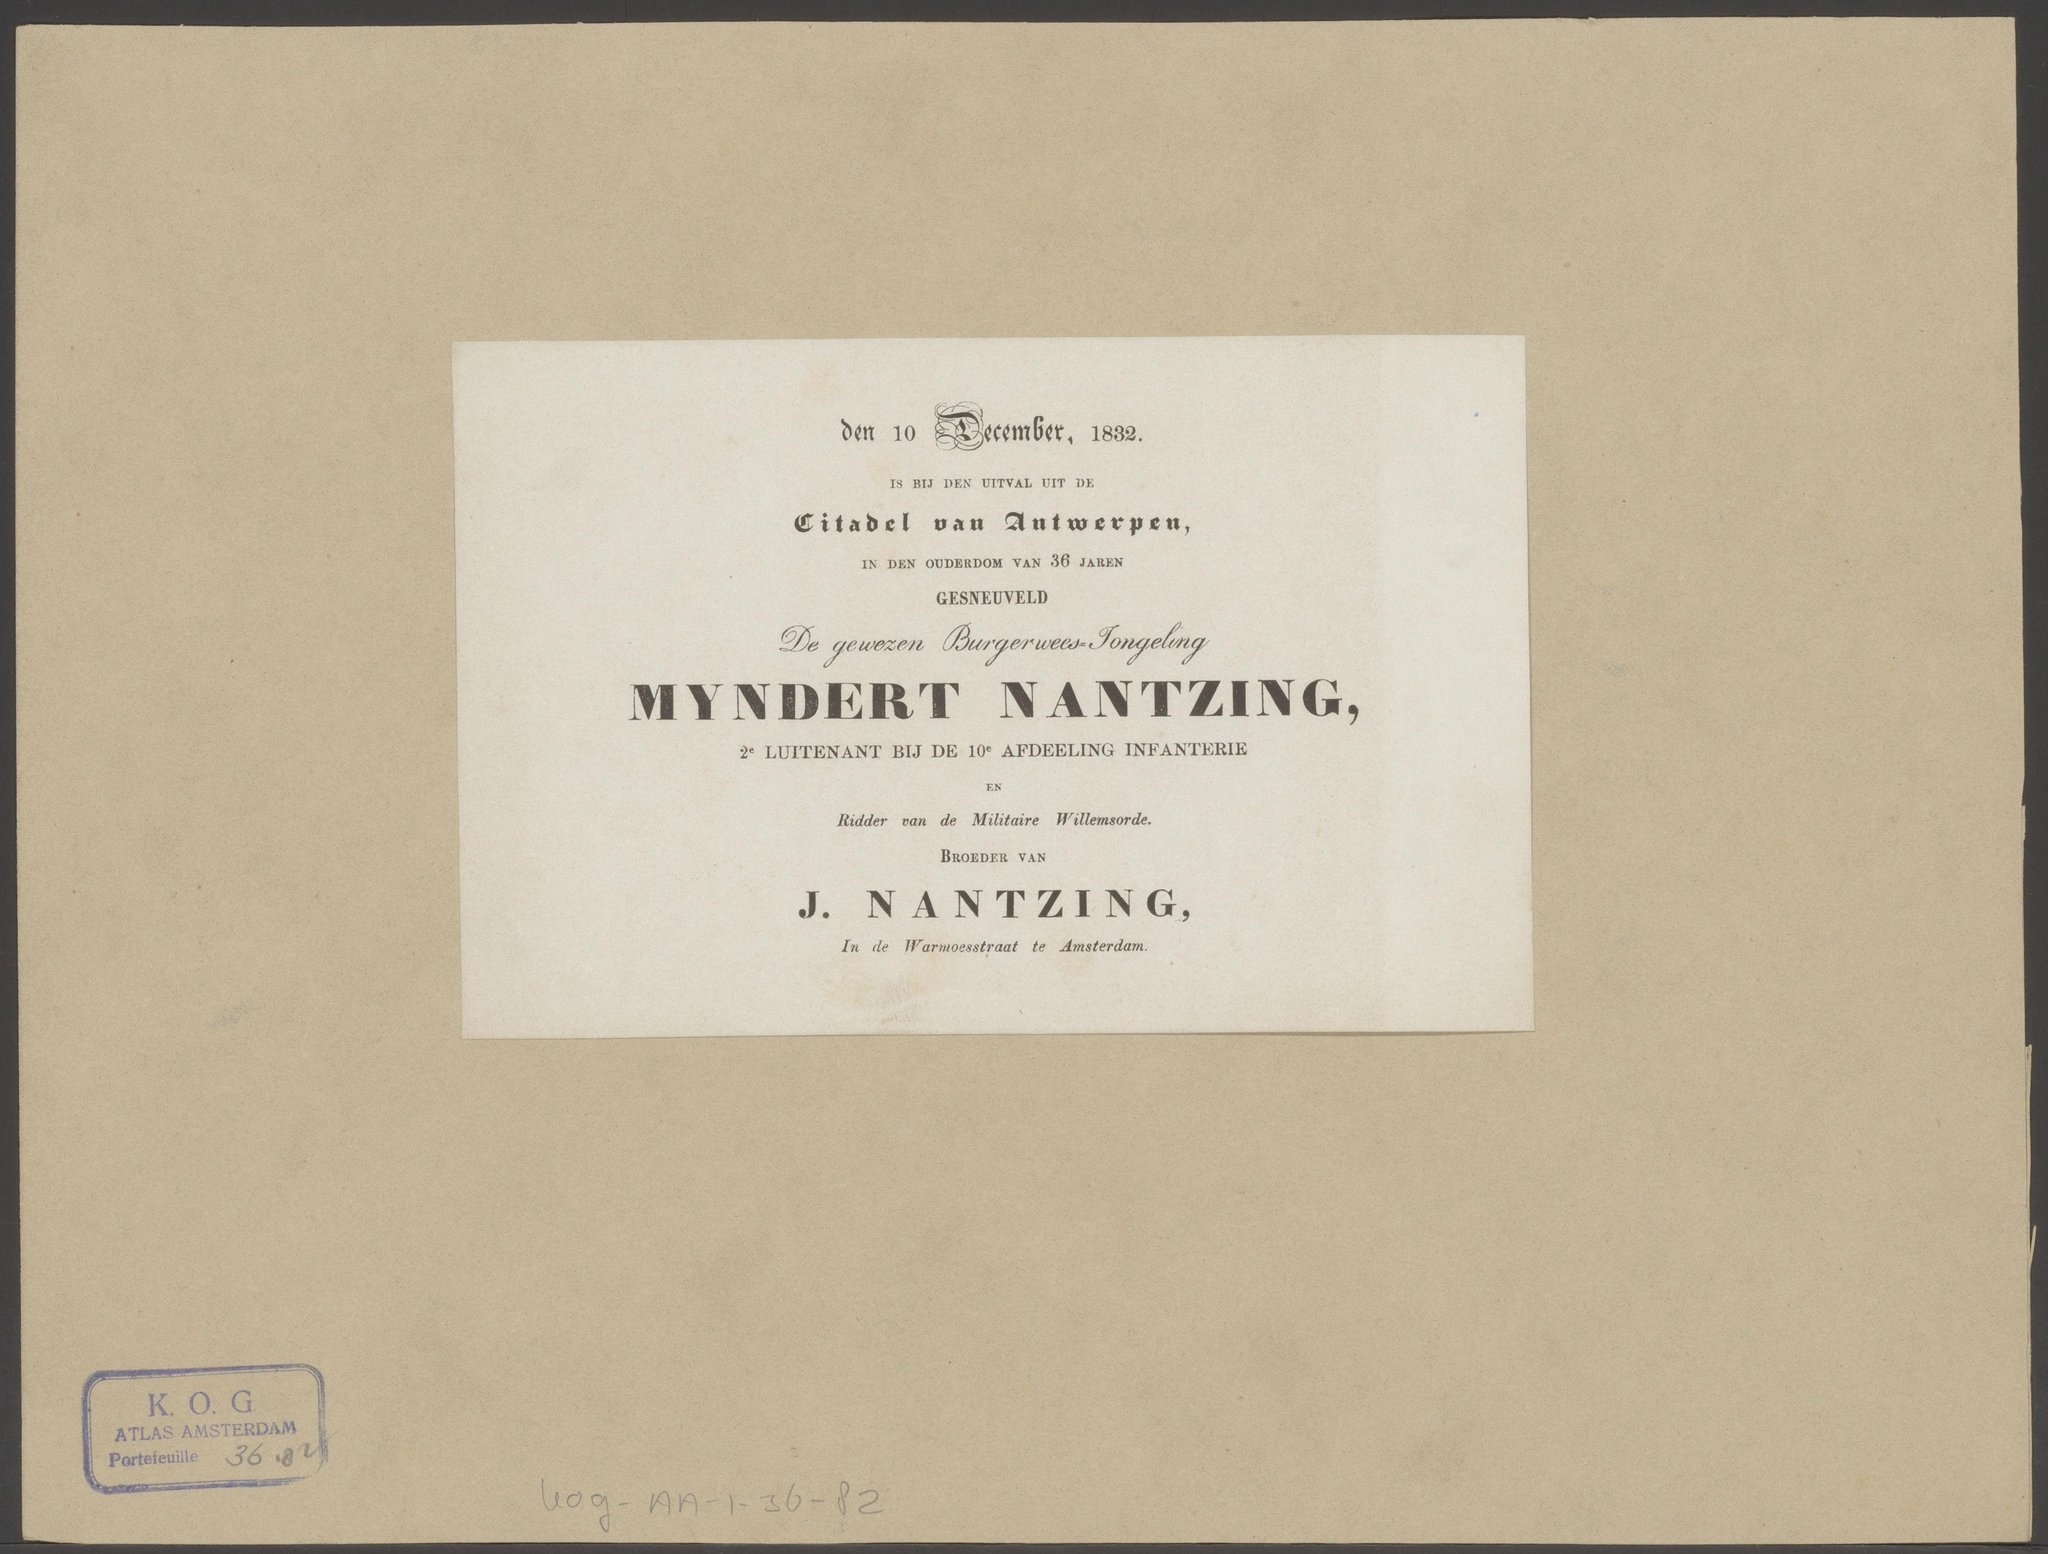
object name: text sheet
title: Gedenkblad Meindert Nantzing, 10 december 1832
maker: Anonymous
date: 1832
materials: paper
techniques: letterpress printing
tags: burgerweeshuis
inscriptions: collector's mark: Lugt 1641b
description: Onderwerpsrubriek binnen de Atlas Amsterdam: Armwezen en liefdadige instellingen: I. Stadsinrichtingen: Burgerweeshuis.